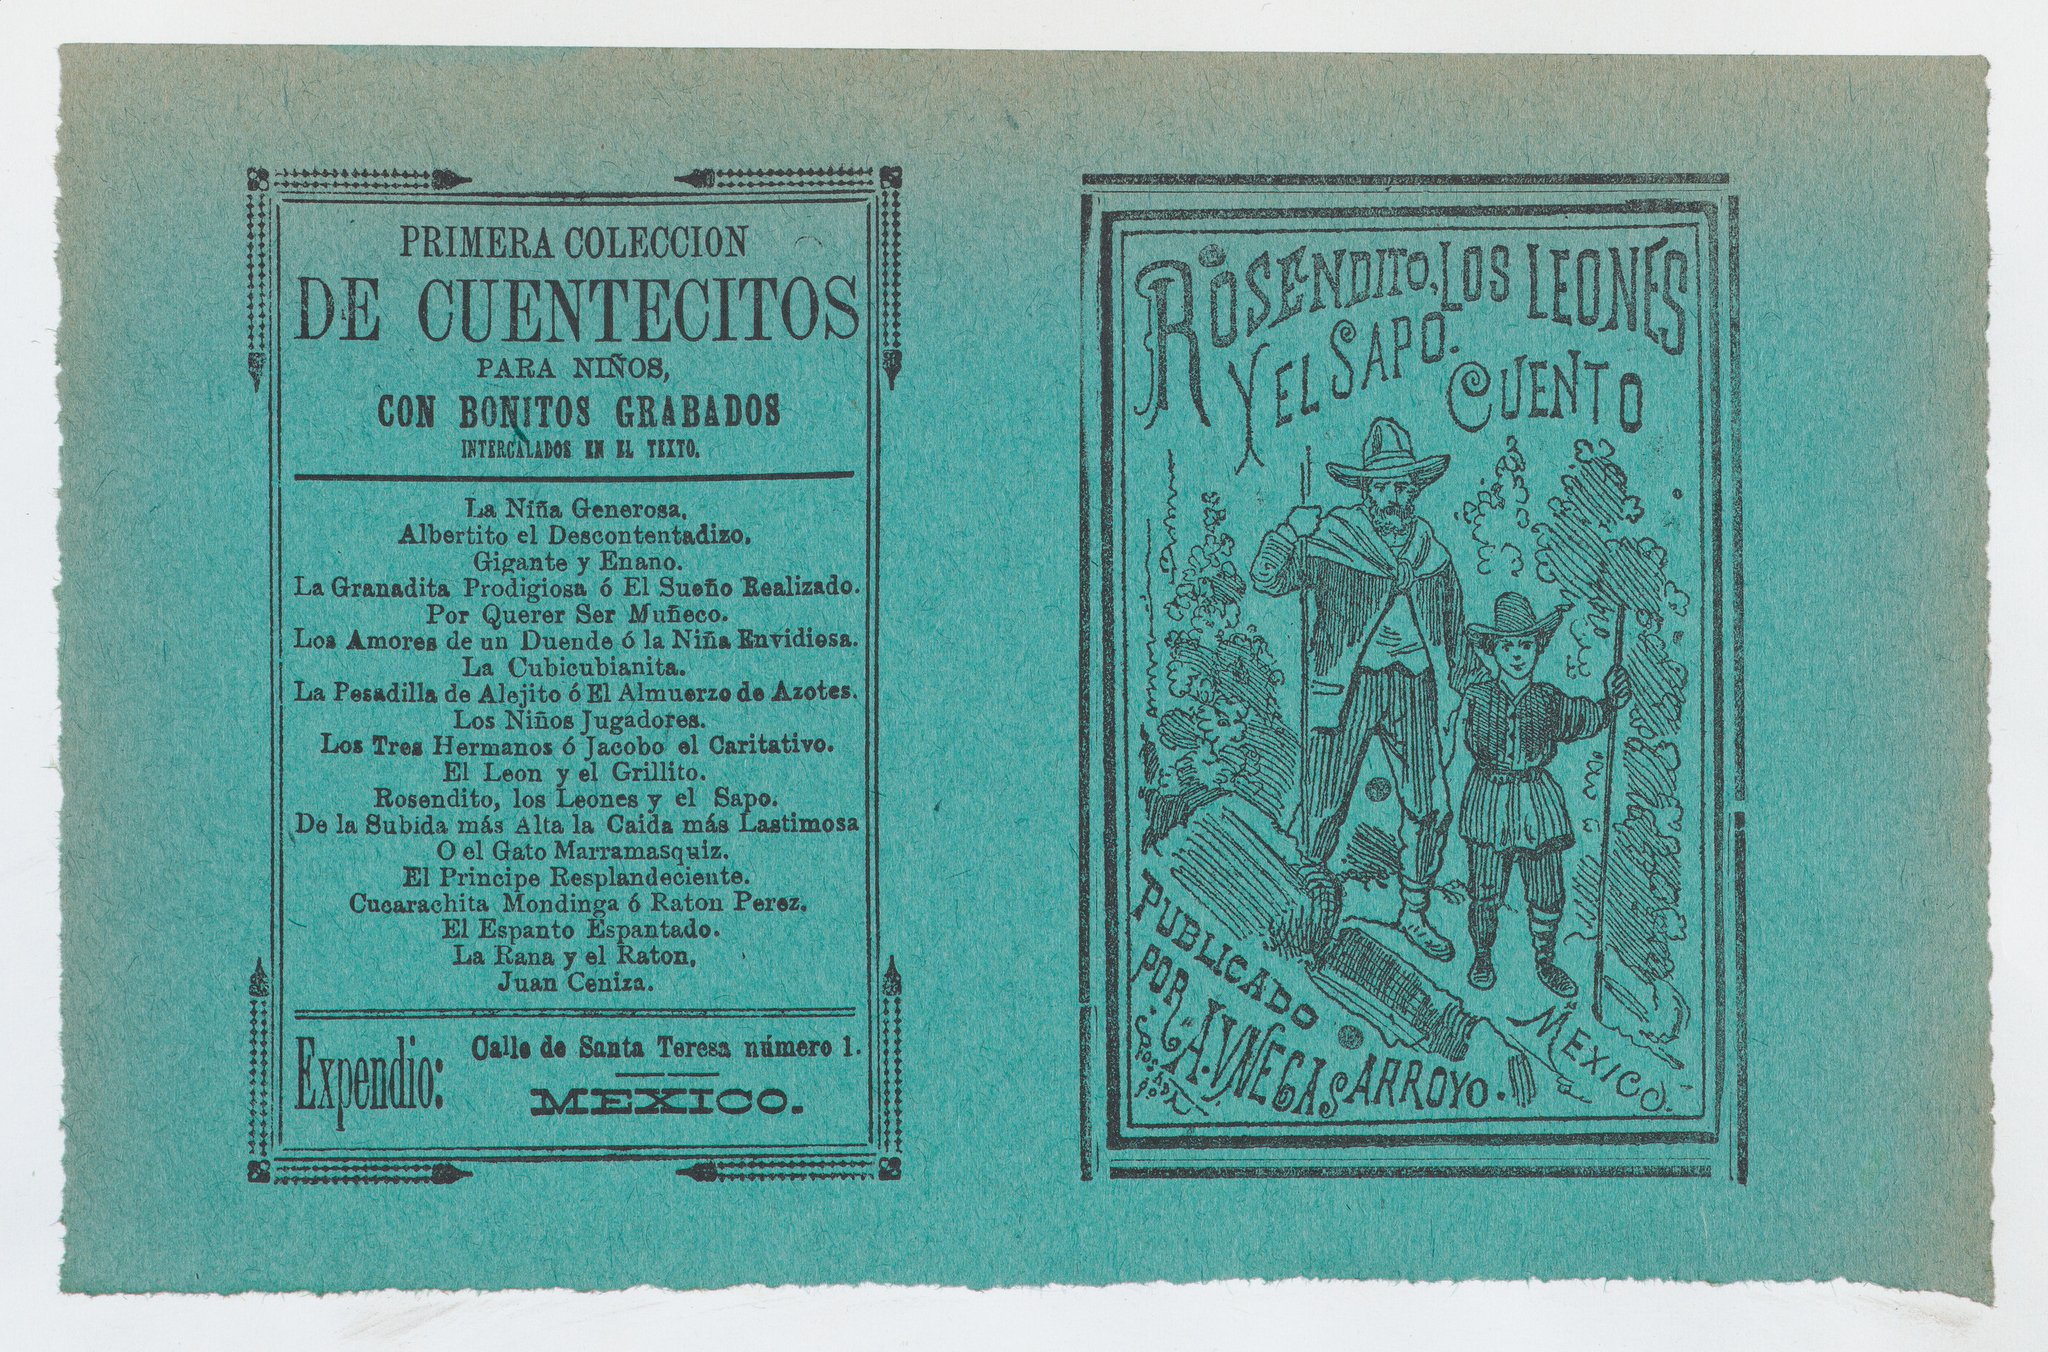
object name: print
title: Cover for 'Rosendito, Los Leones, y El Sapo', a young boy and man holding walking sticks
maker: josé guadalupe posada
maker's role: artist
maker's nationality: mexican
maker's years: 1852-1913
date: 1890-1910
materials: paper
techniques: letterpress, printing, lithography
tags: men,women